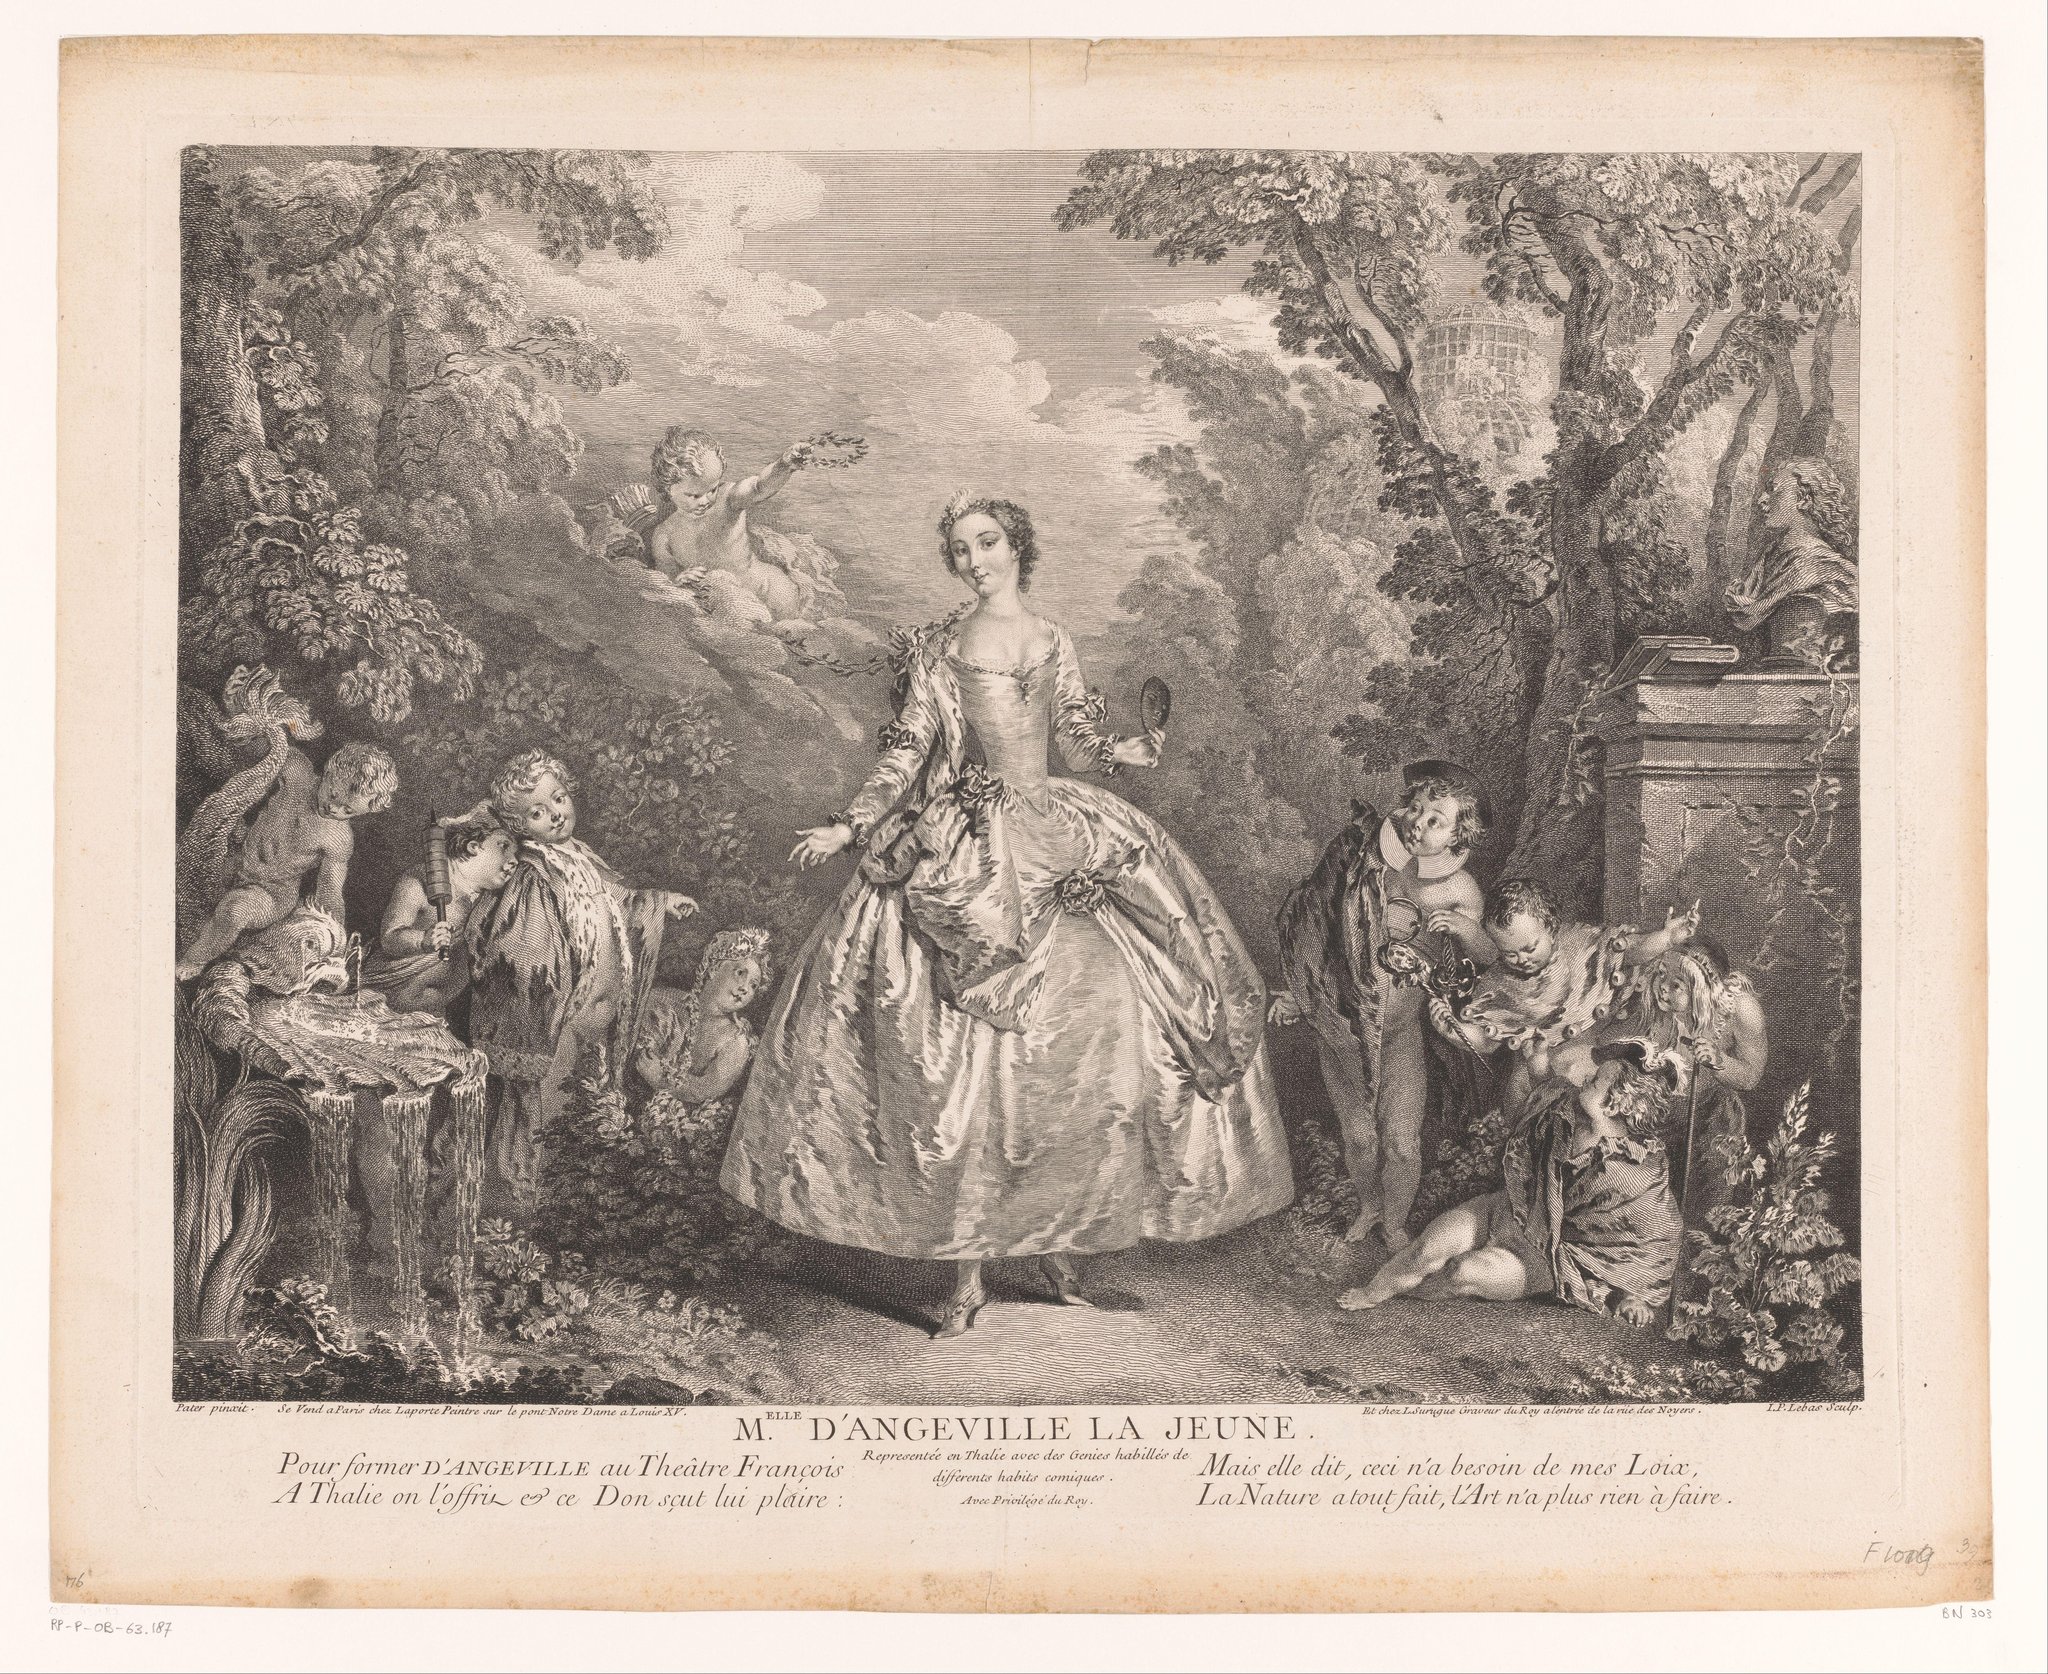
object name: print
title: Mlle D'Angeville la Jeune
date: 1732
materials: paper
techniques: engraving, etching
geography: paris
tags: paris, historical persons, portrait of actor, actress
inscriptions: collector's mark: Lugt 240